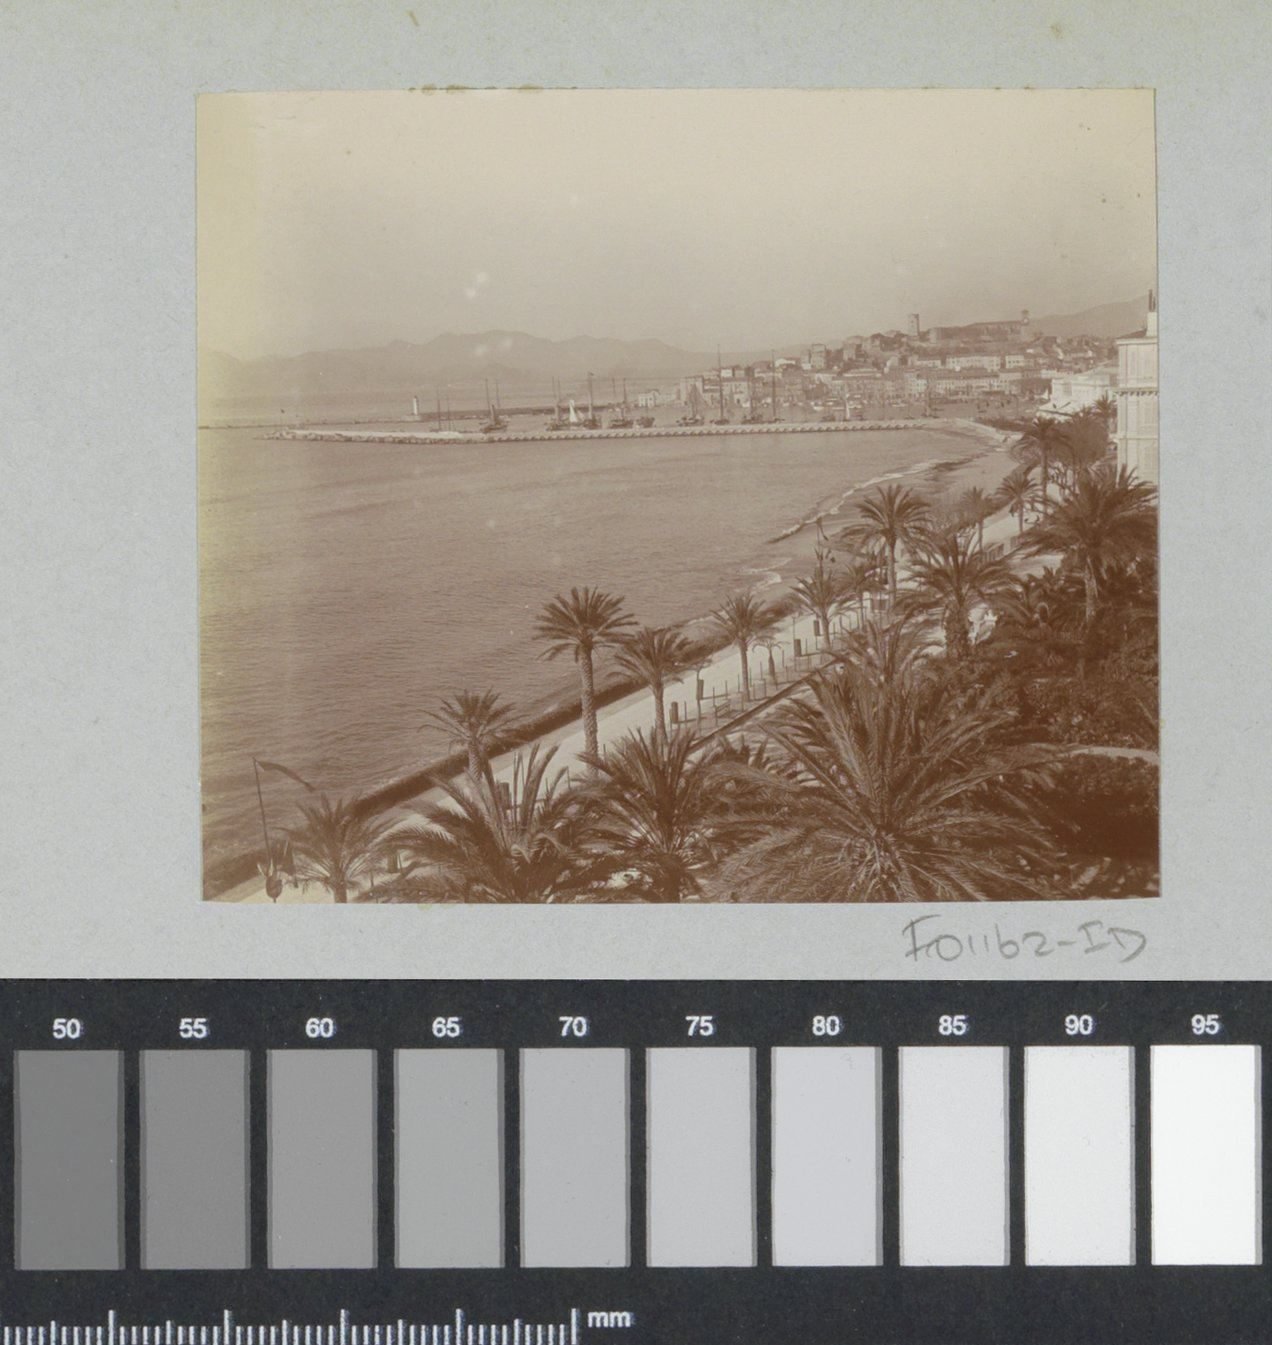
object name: photograph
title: Gezicht op een vermoedelijk Franse stad aan de Middellandse Zee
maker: Anonymous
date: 1905-1910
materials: paper, photographic support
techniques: gelatin silver print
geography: southern france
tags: avenue, boulevard, promenade, esplanade (+ city(-scape) with figures, staffage), trees: palm-tree, prospect of city, town panorama, silhouette of city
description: Onderdeel van Fotoalbum van een Franse amateurfotograaf met bezienswaardigheden in Frankrijk, Zwitserland en Italië.